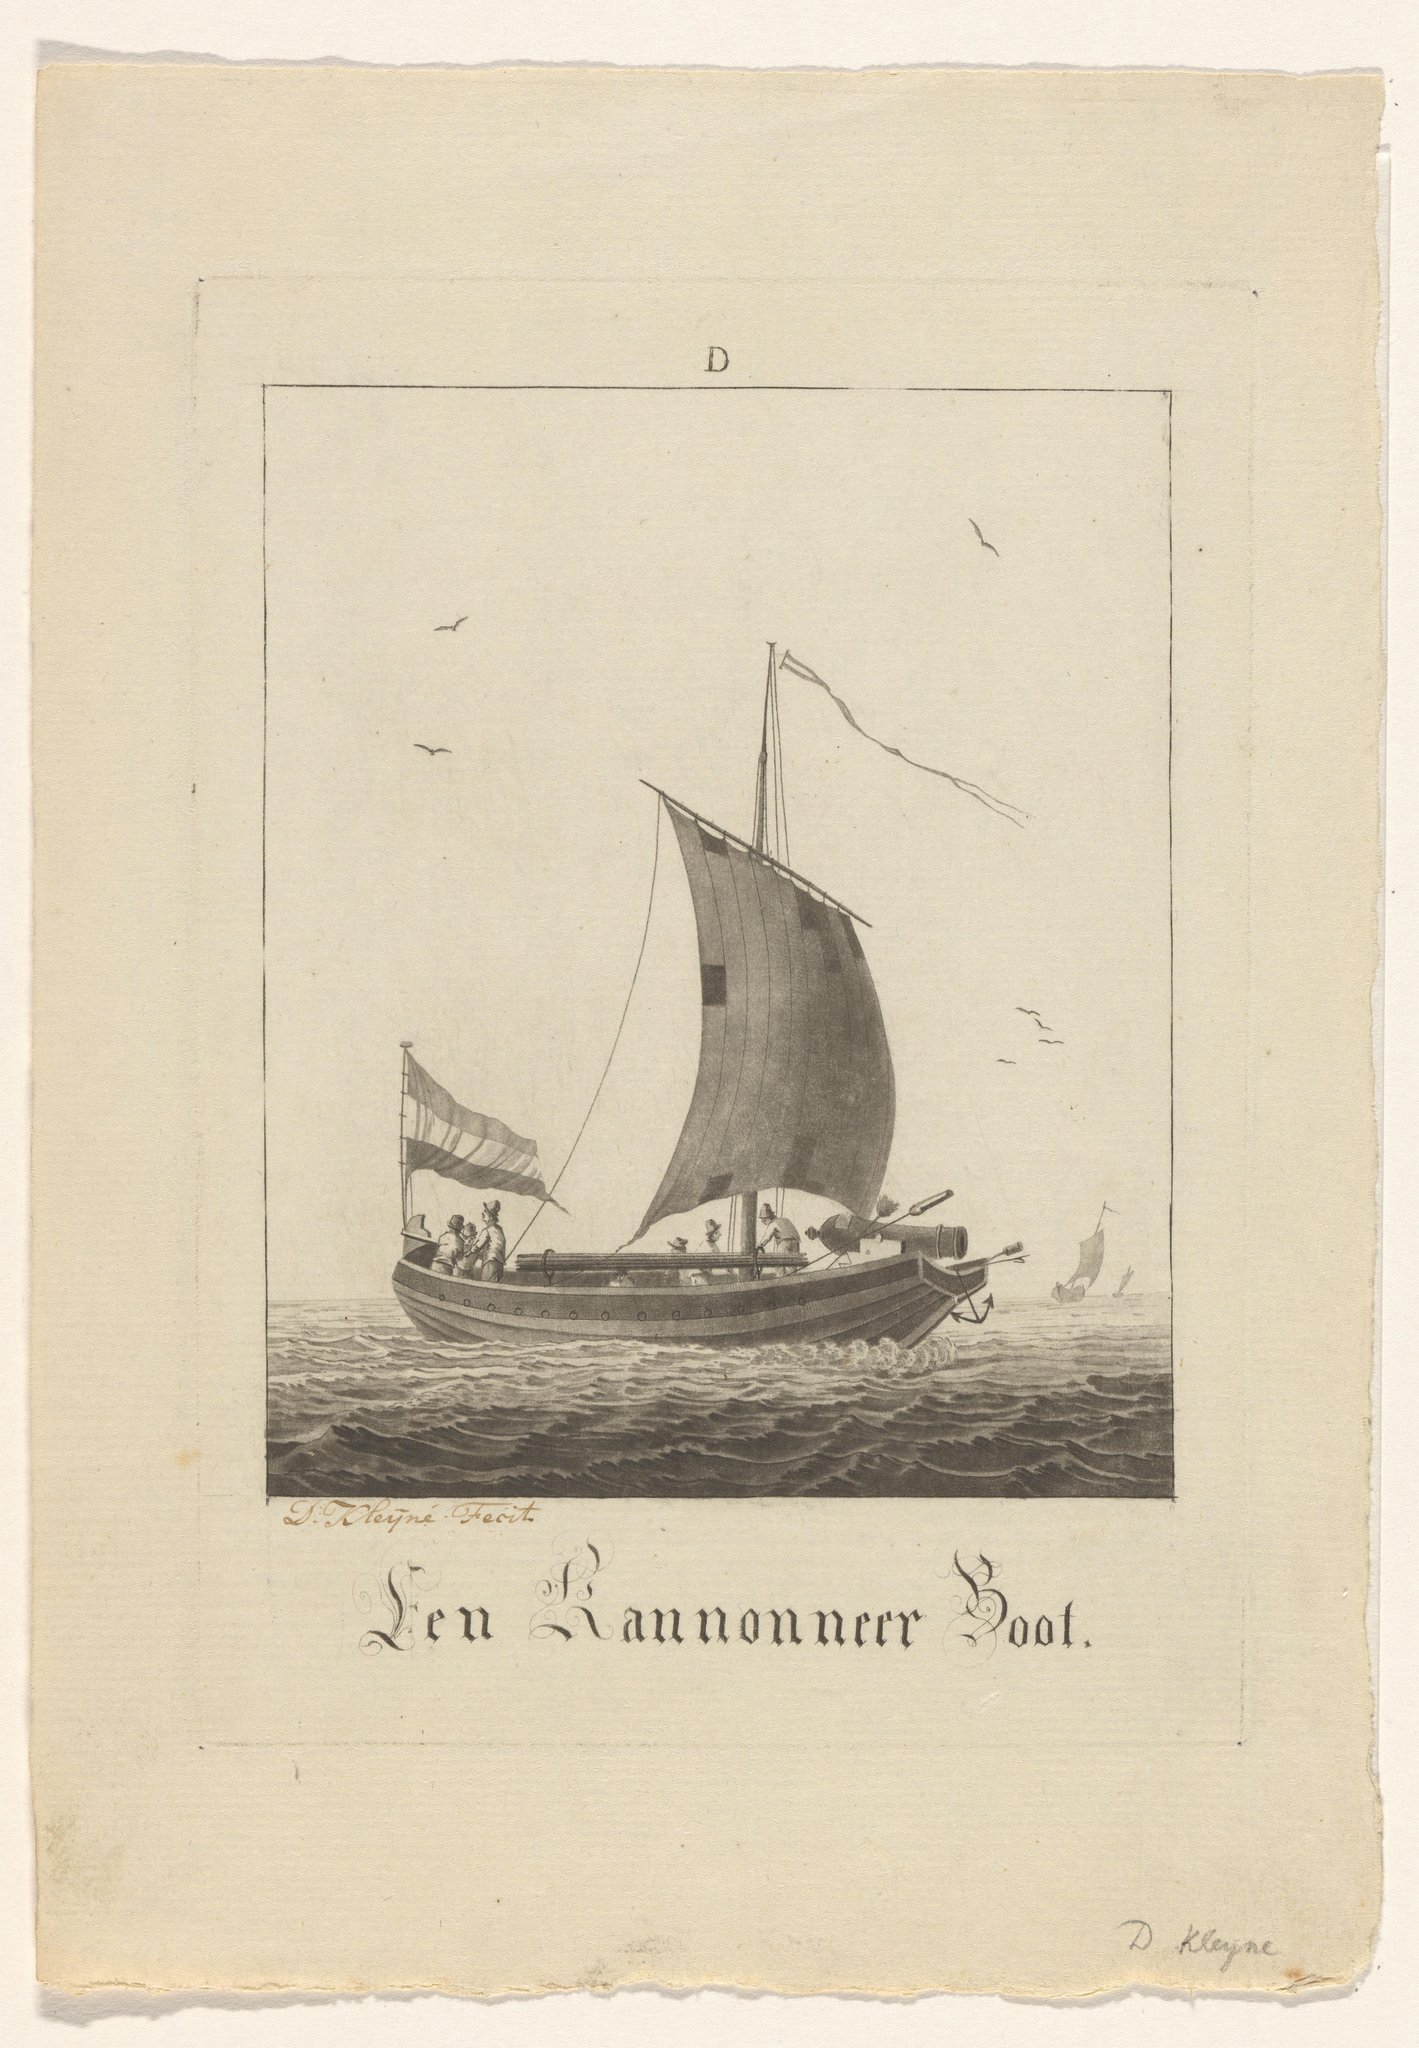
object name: print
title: Een kannonneer boot (D)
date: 1764-1805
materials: paper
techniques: aquatint, etching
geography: netherlands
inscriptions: inscription: ‘D. Kleijne Fecit’